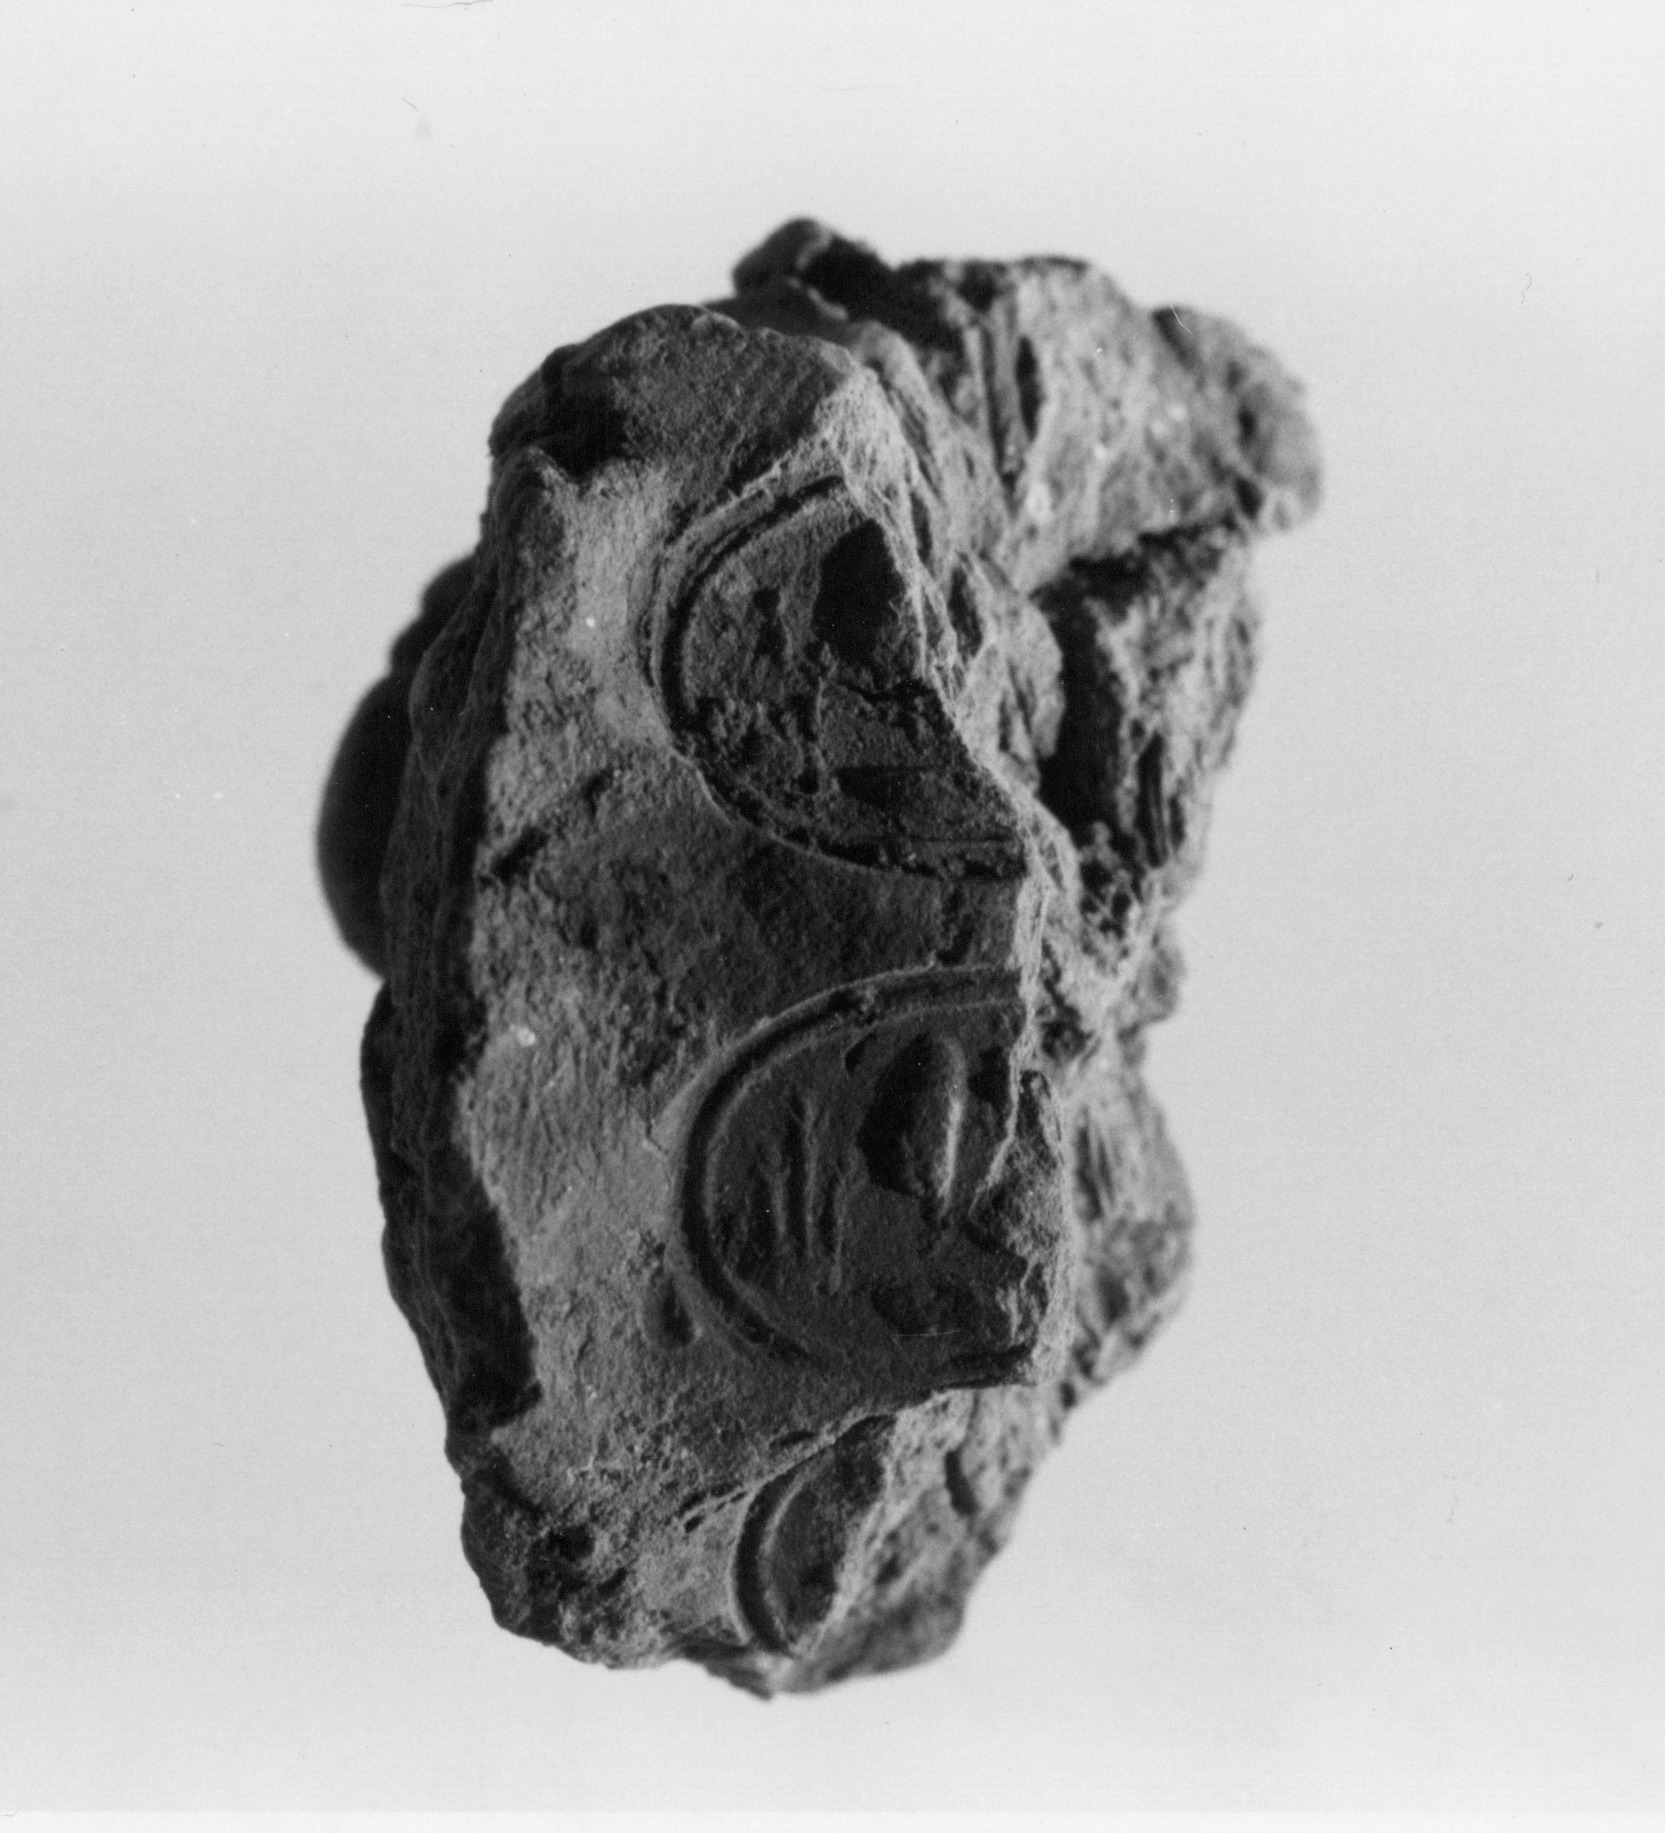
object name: sealing, upper egypt, lower egypt, amun re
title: Document Sealing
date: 1390-1352 BCE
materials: mud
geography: egypt